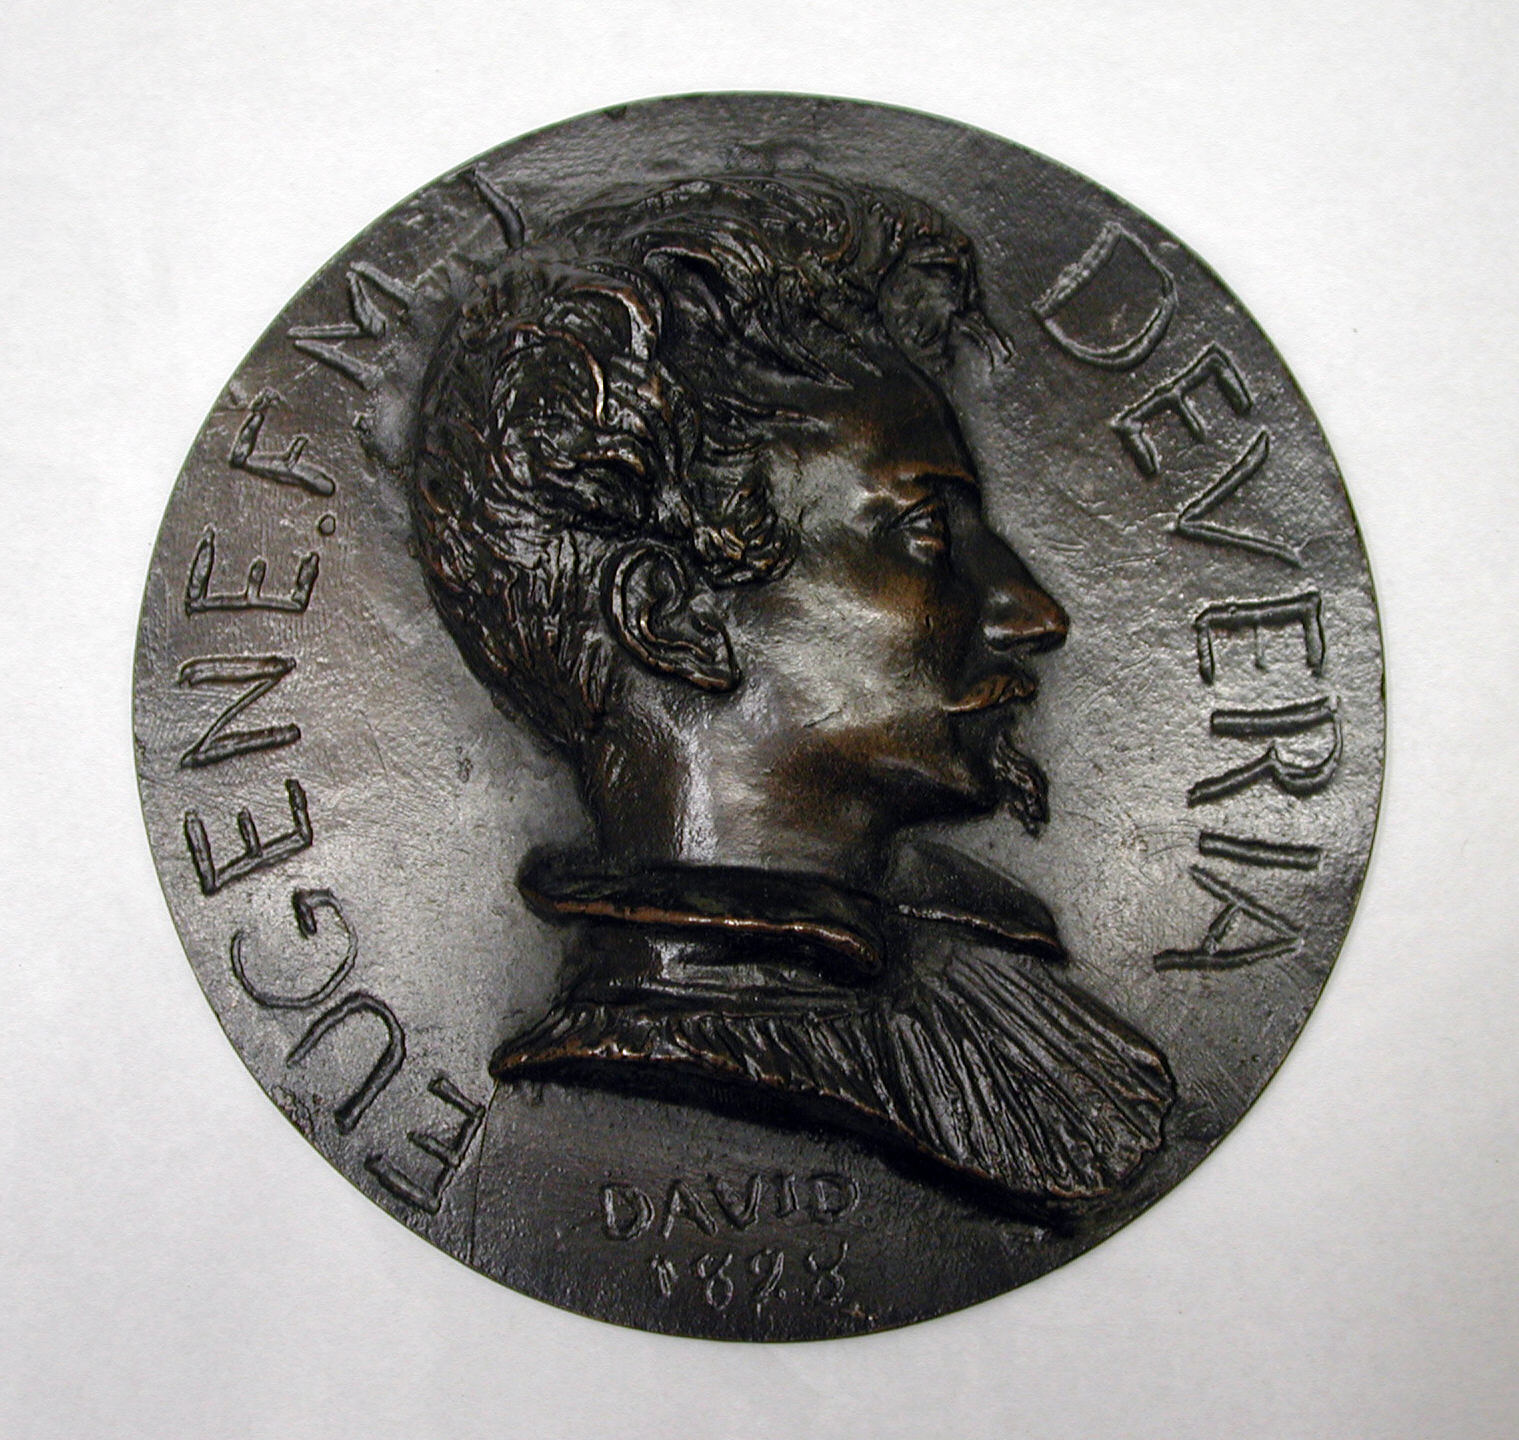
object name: medallion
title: Eugène F.-M.-J. Devéria (1805–1865), painter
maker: pierre jean david d'angers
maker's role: maker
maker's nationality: french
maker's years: 1788-1856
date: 1828-1838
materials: bronze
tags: men,profiles